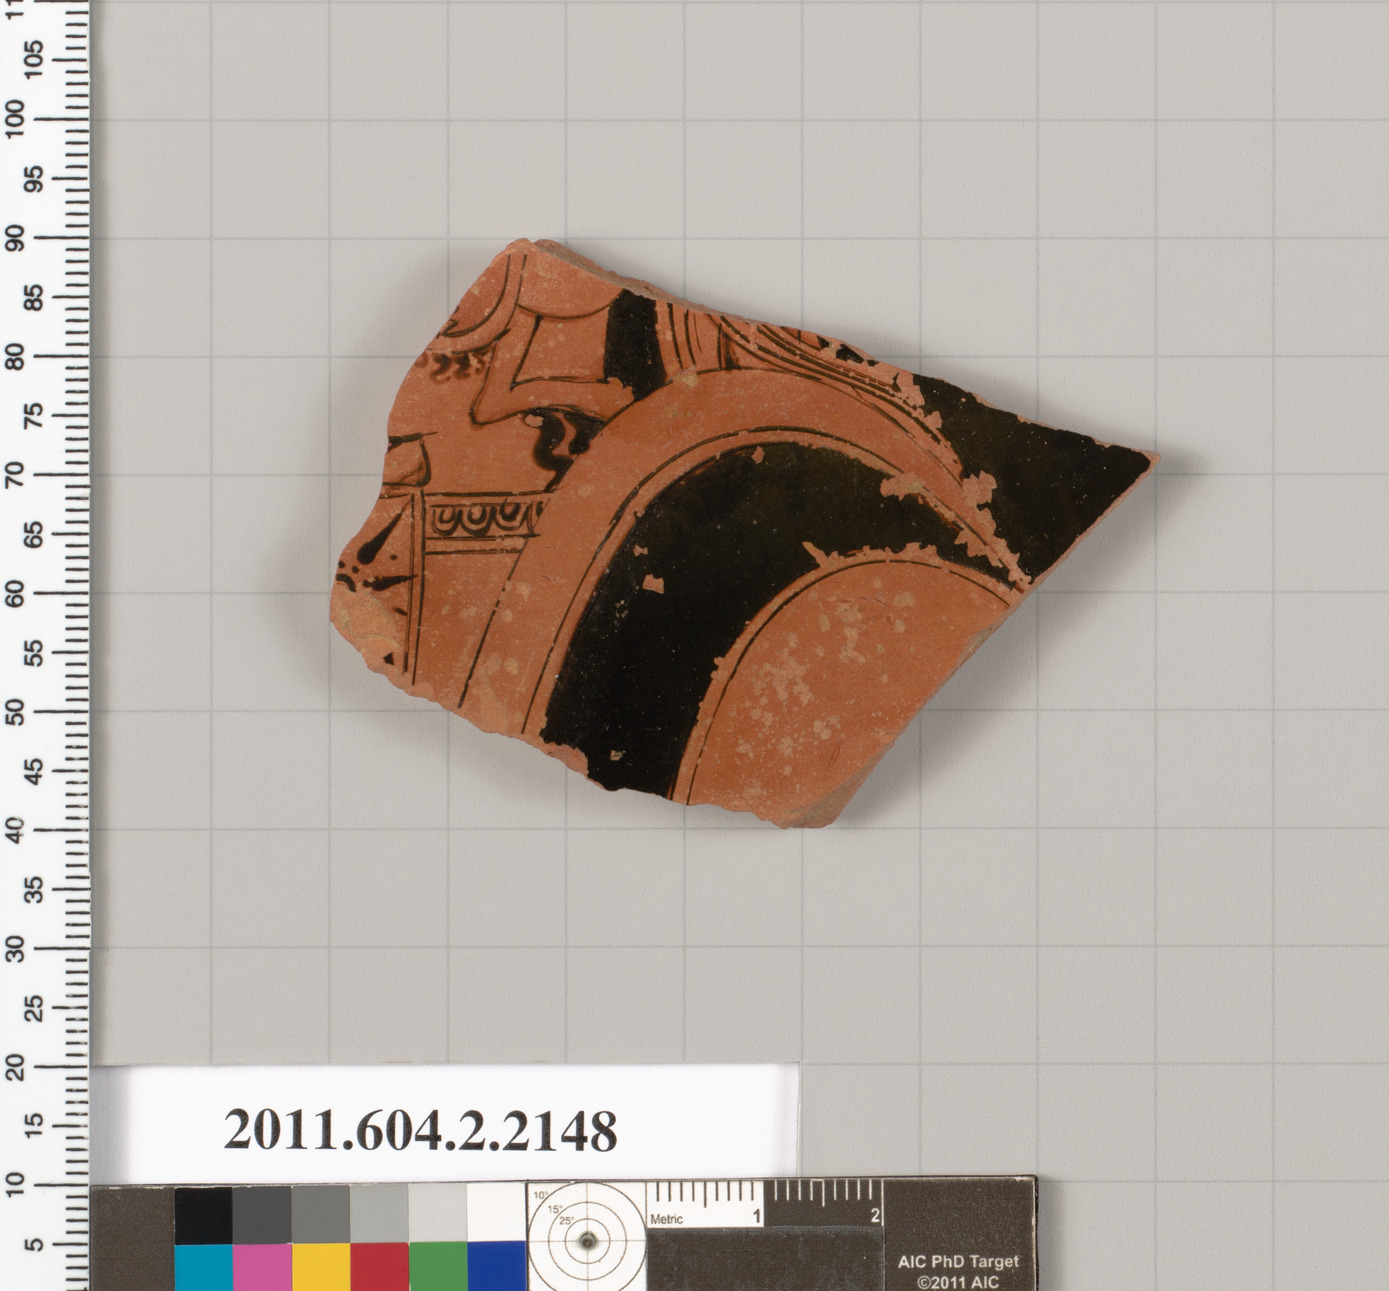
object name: pot fragment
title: Terracotta fragment of a pot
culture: greek, attic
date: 460-440 BCE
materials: terracotta